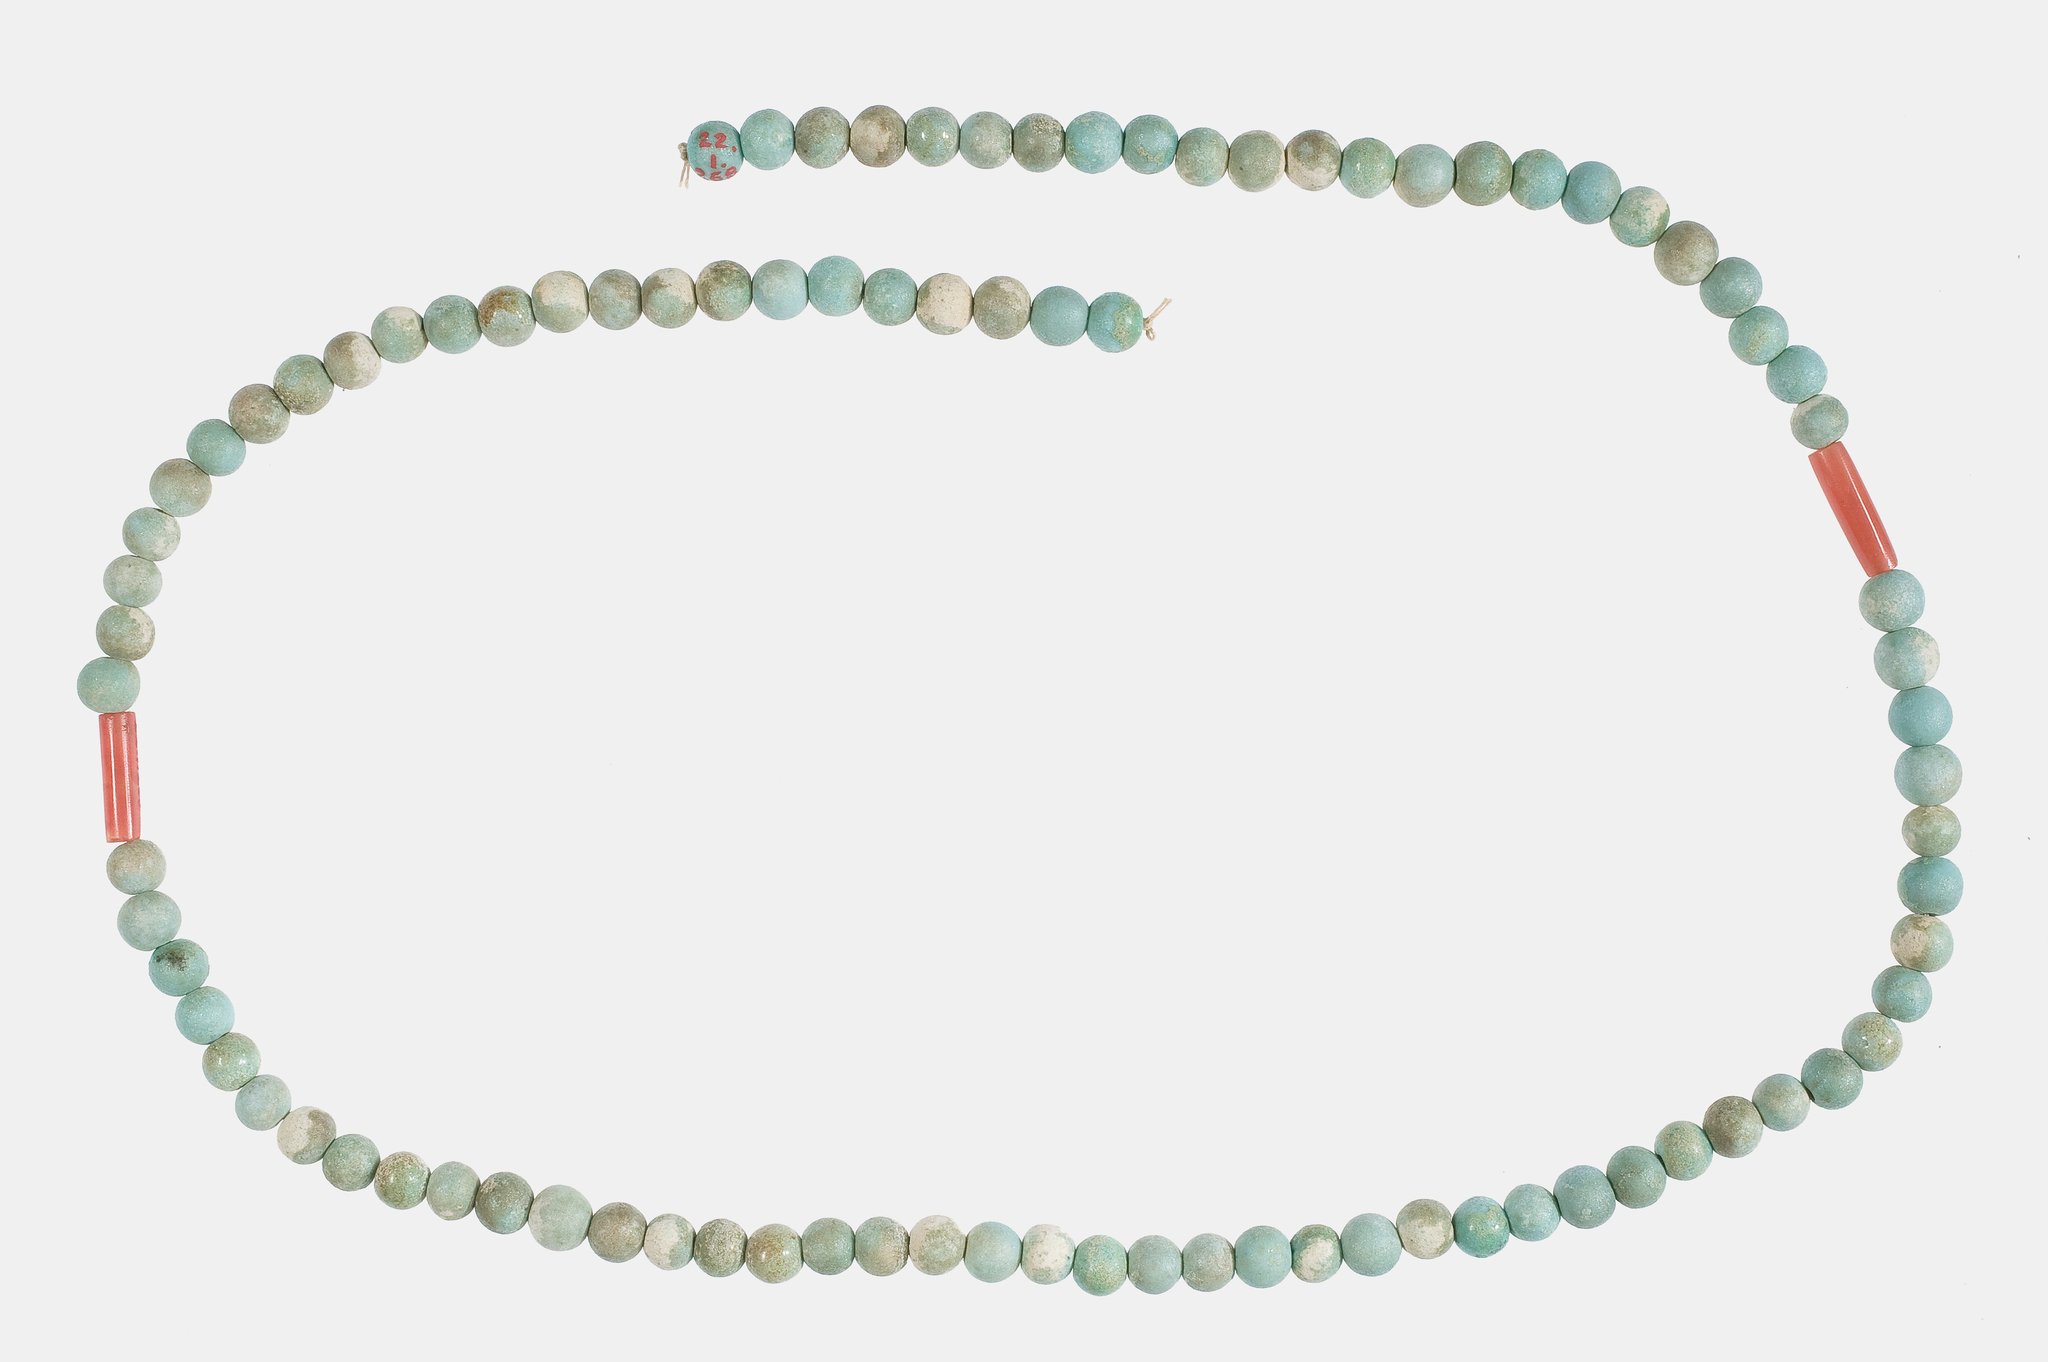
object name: necklace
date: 1981-1640 BCE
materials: gemstone, faience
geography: egypt